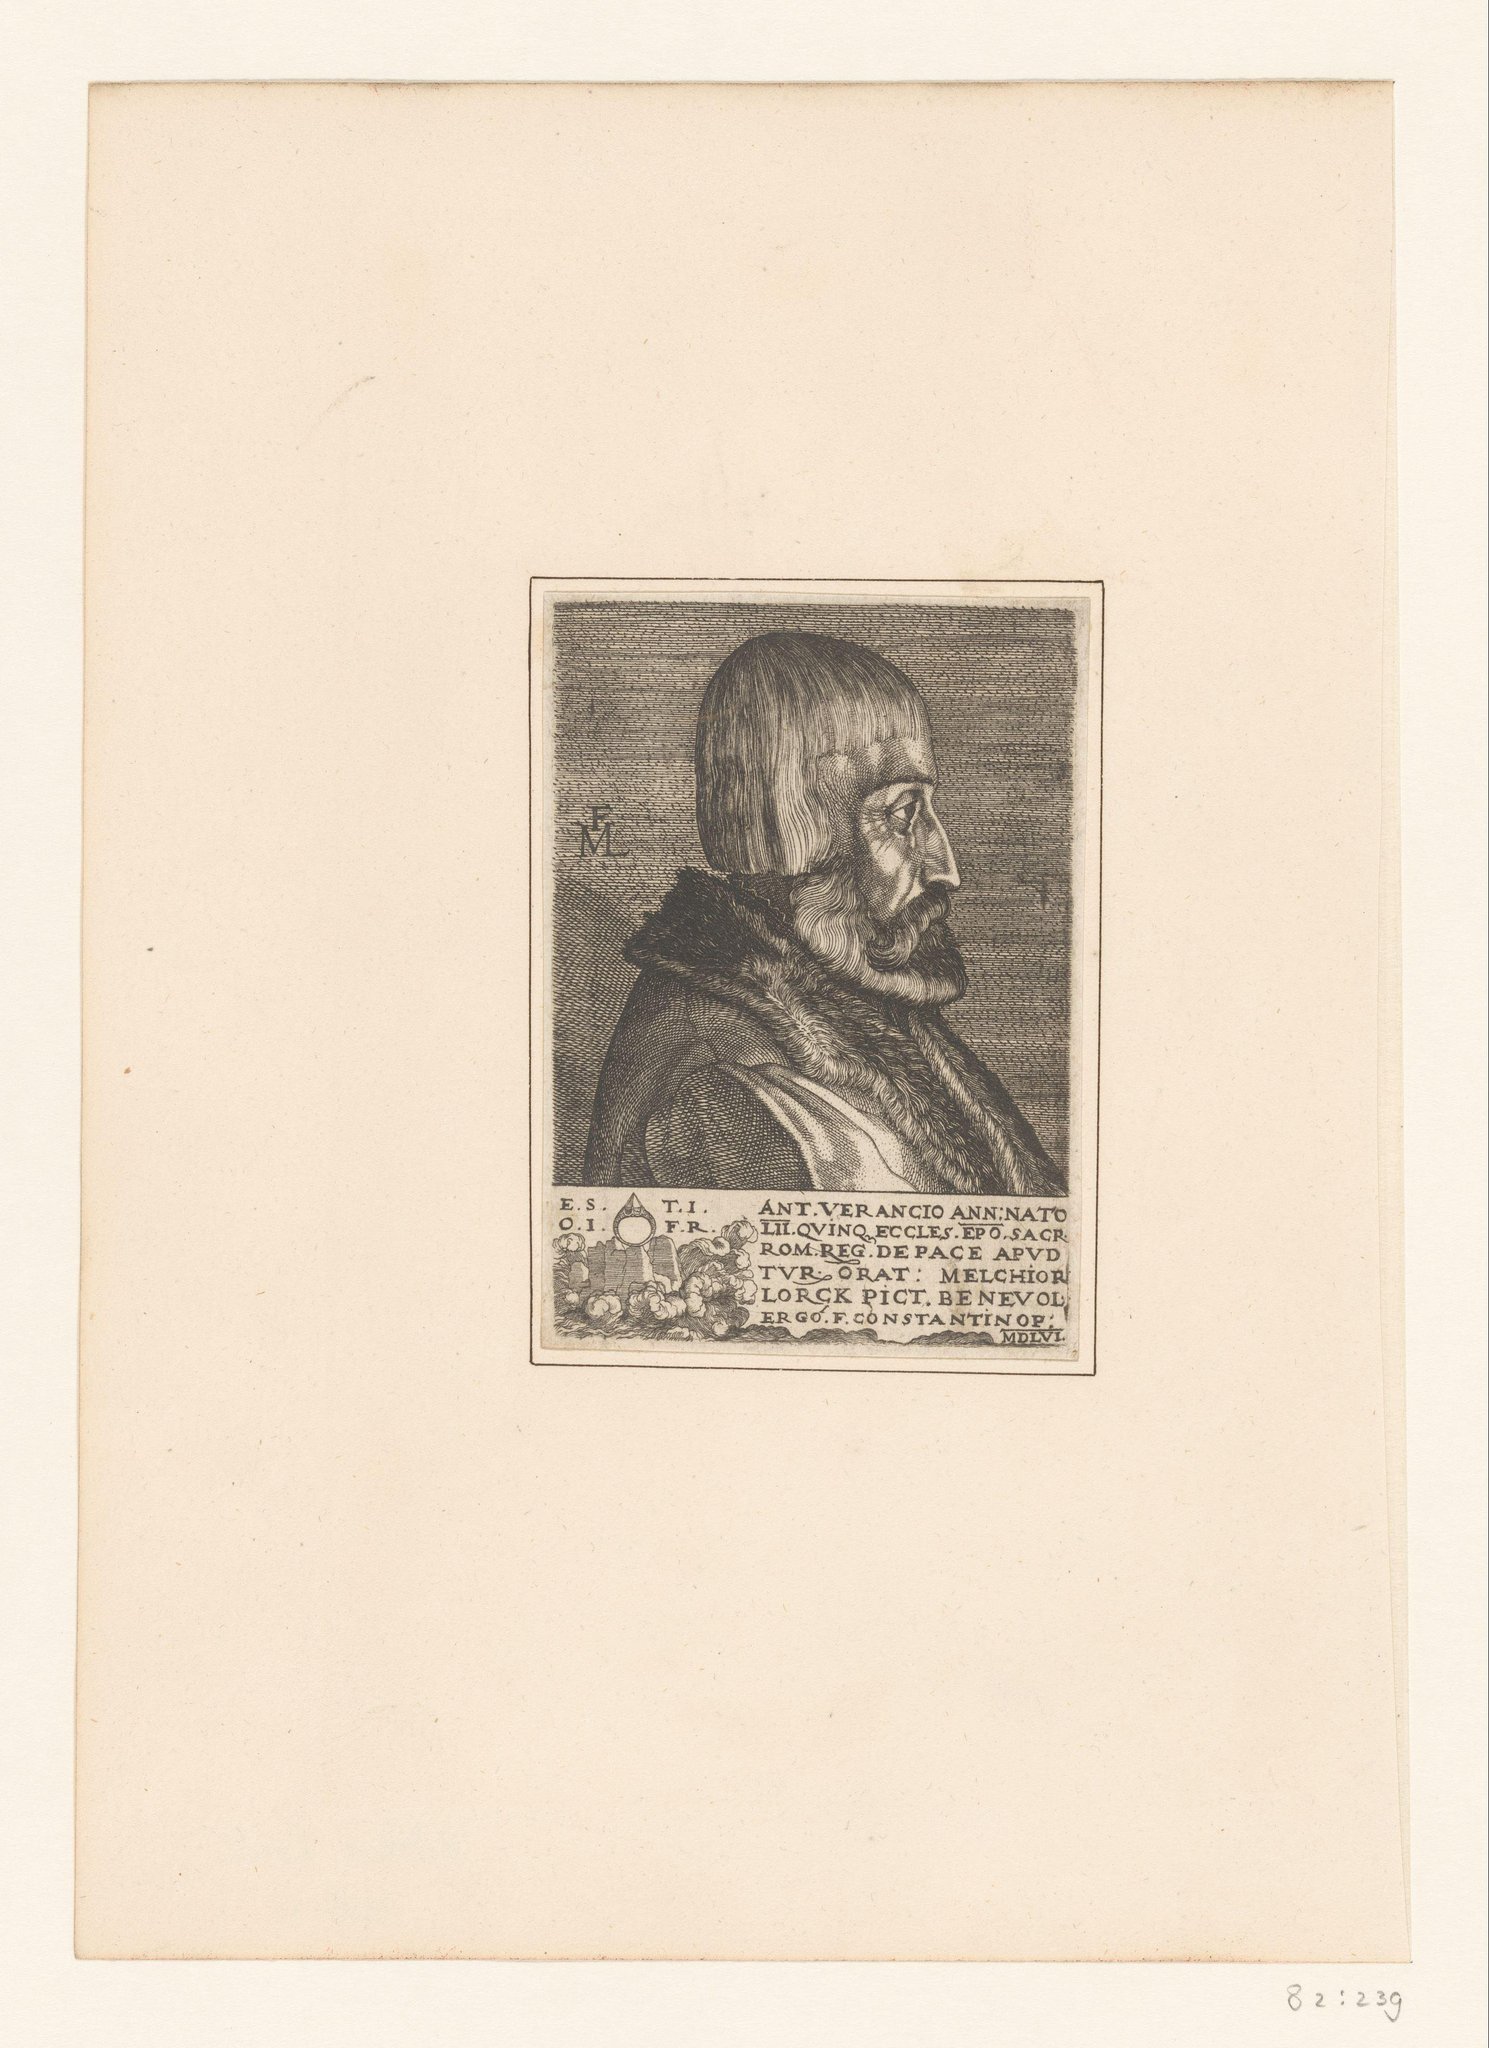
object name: print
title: Portret van Antun Vrančić, bisschop en ambassadeur, 1556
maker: melchior lorck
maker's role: draughtsman, painter, print maker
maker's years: 1526-1588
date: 1556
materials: paper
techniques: engraving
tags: archbishop, bishop, etc. (roman catholic), historical persons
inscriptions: collector's mark: Lugt 2228, collector's mark: Lugt 2760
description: Portret van Antun Vrančić (Anton Wranczy of Verantius), bisschop van Pécs en Eger en ambassadeur, 1556.